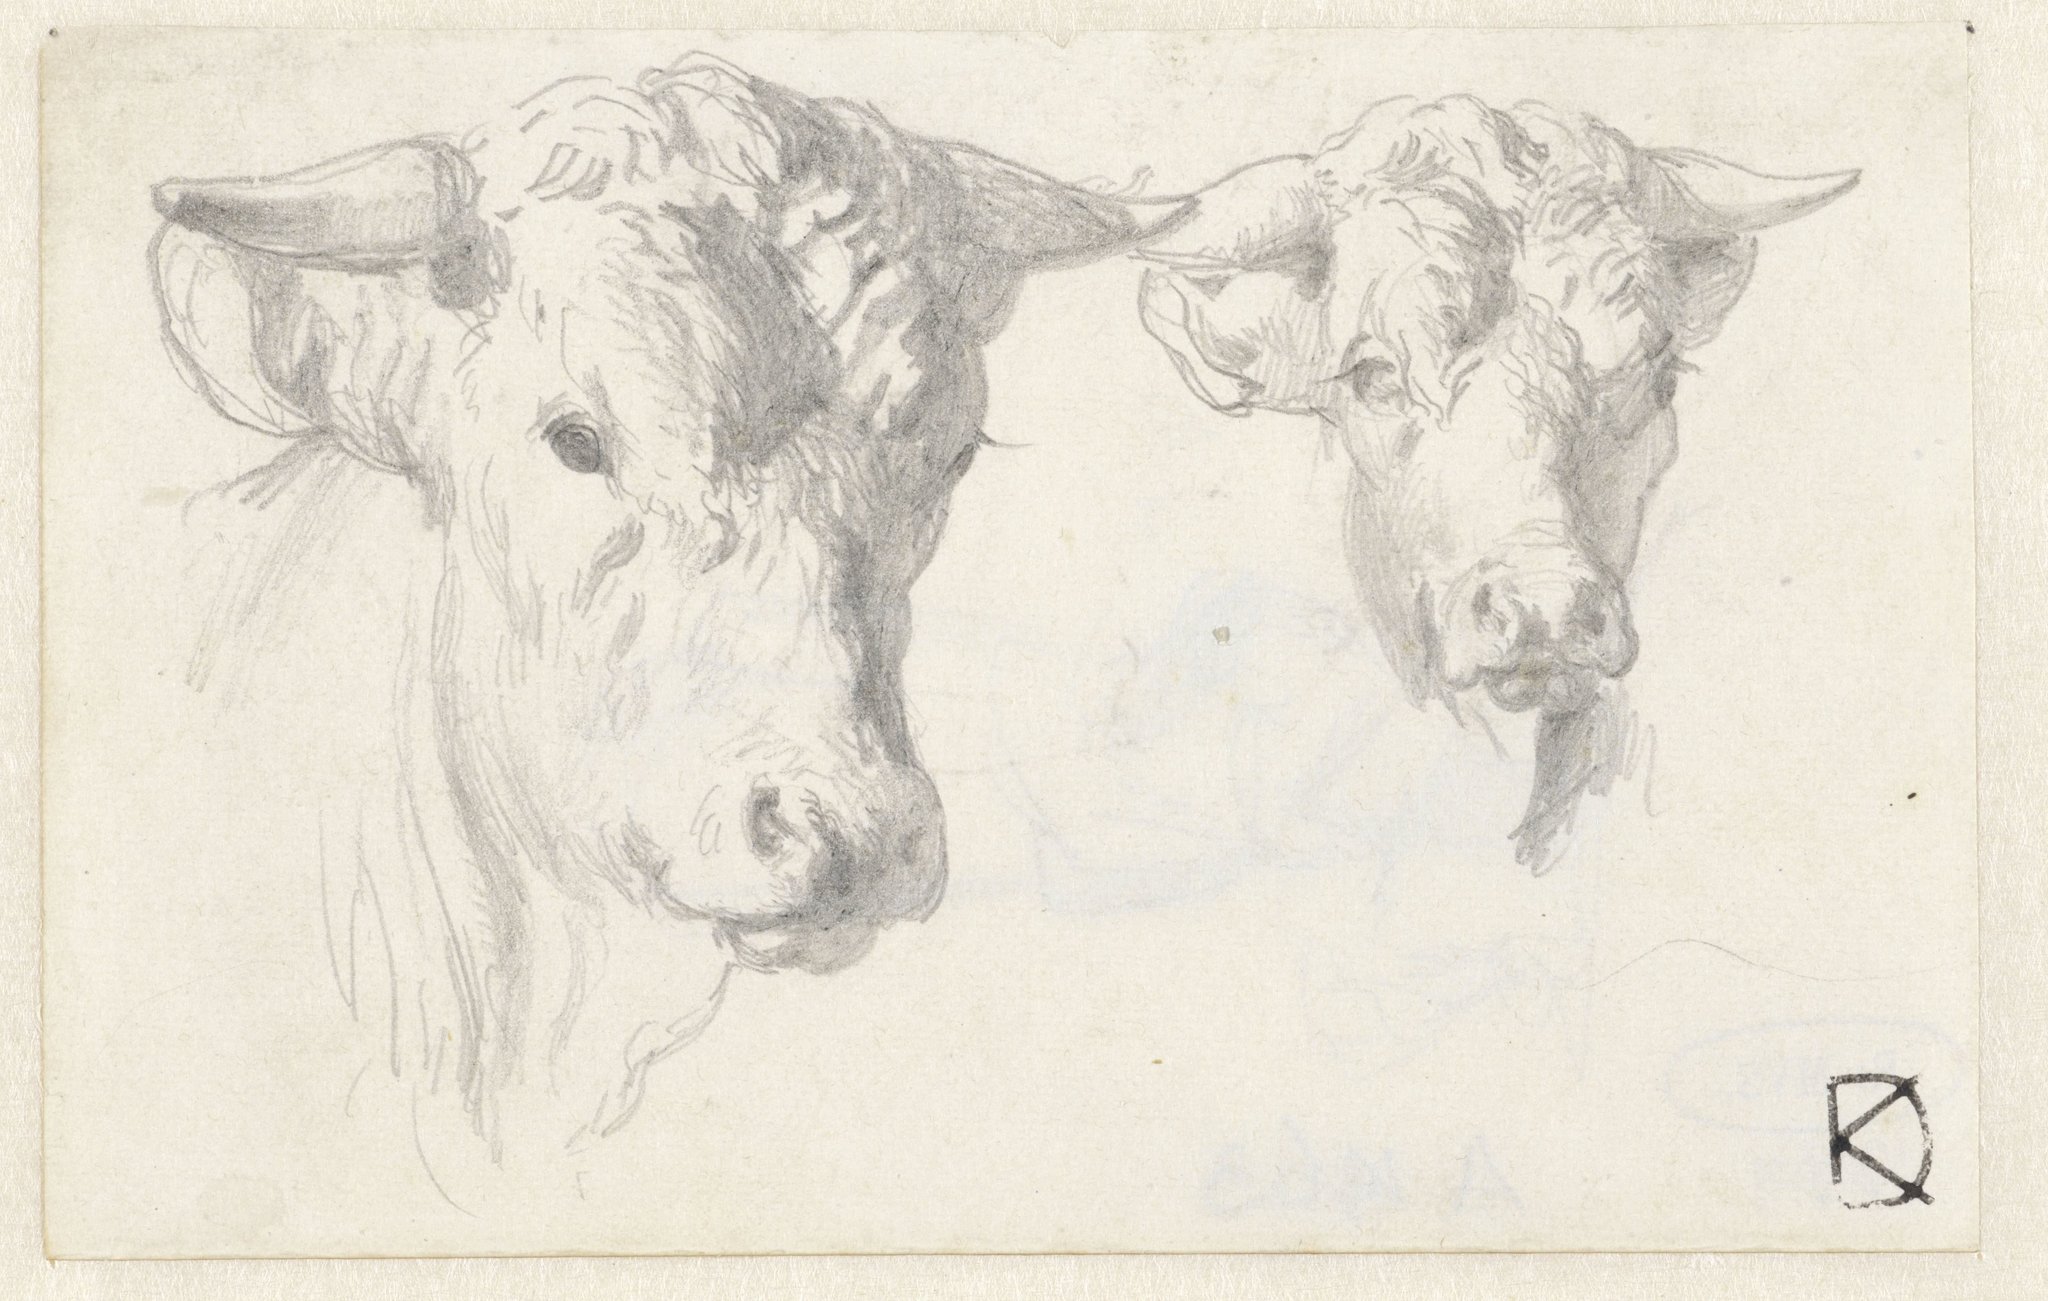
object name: drawing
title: Twee ossenkoppen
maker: johan daniël koelman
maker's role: draughtsman, print maker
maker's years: 1831-1857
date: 1841-1857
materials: paper, pencil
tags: ox (+ head of an animal)